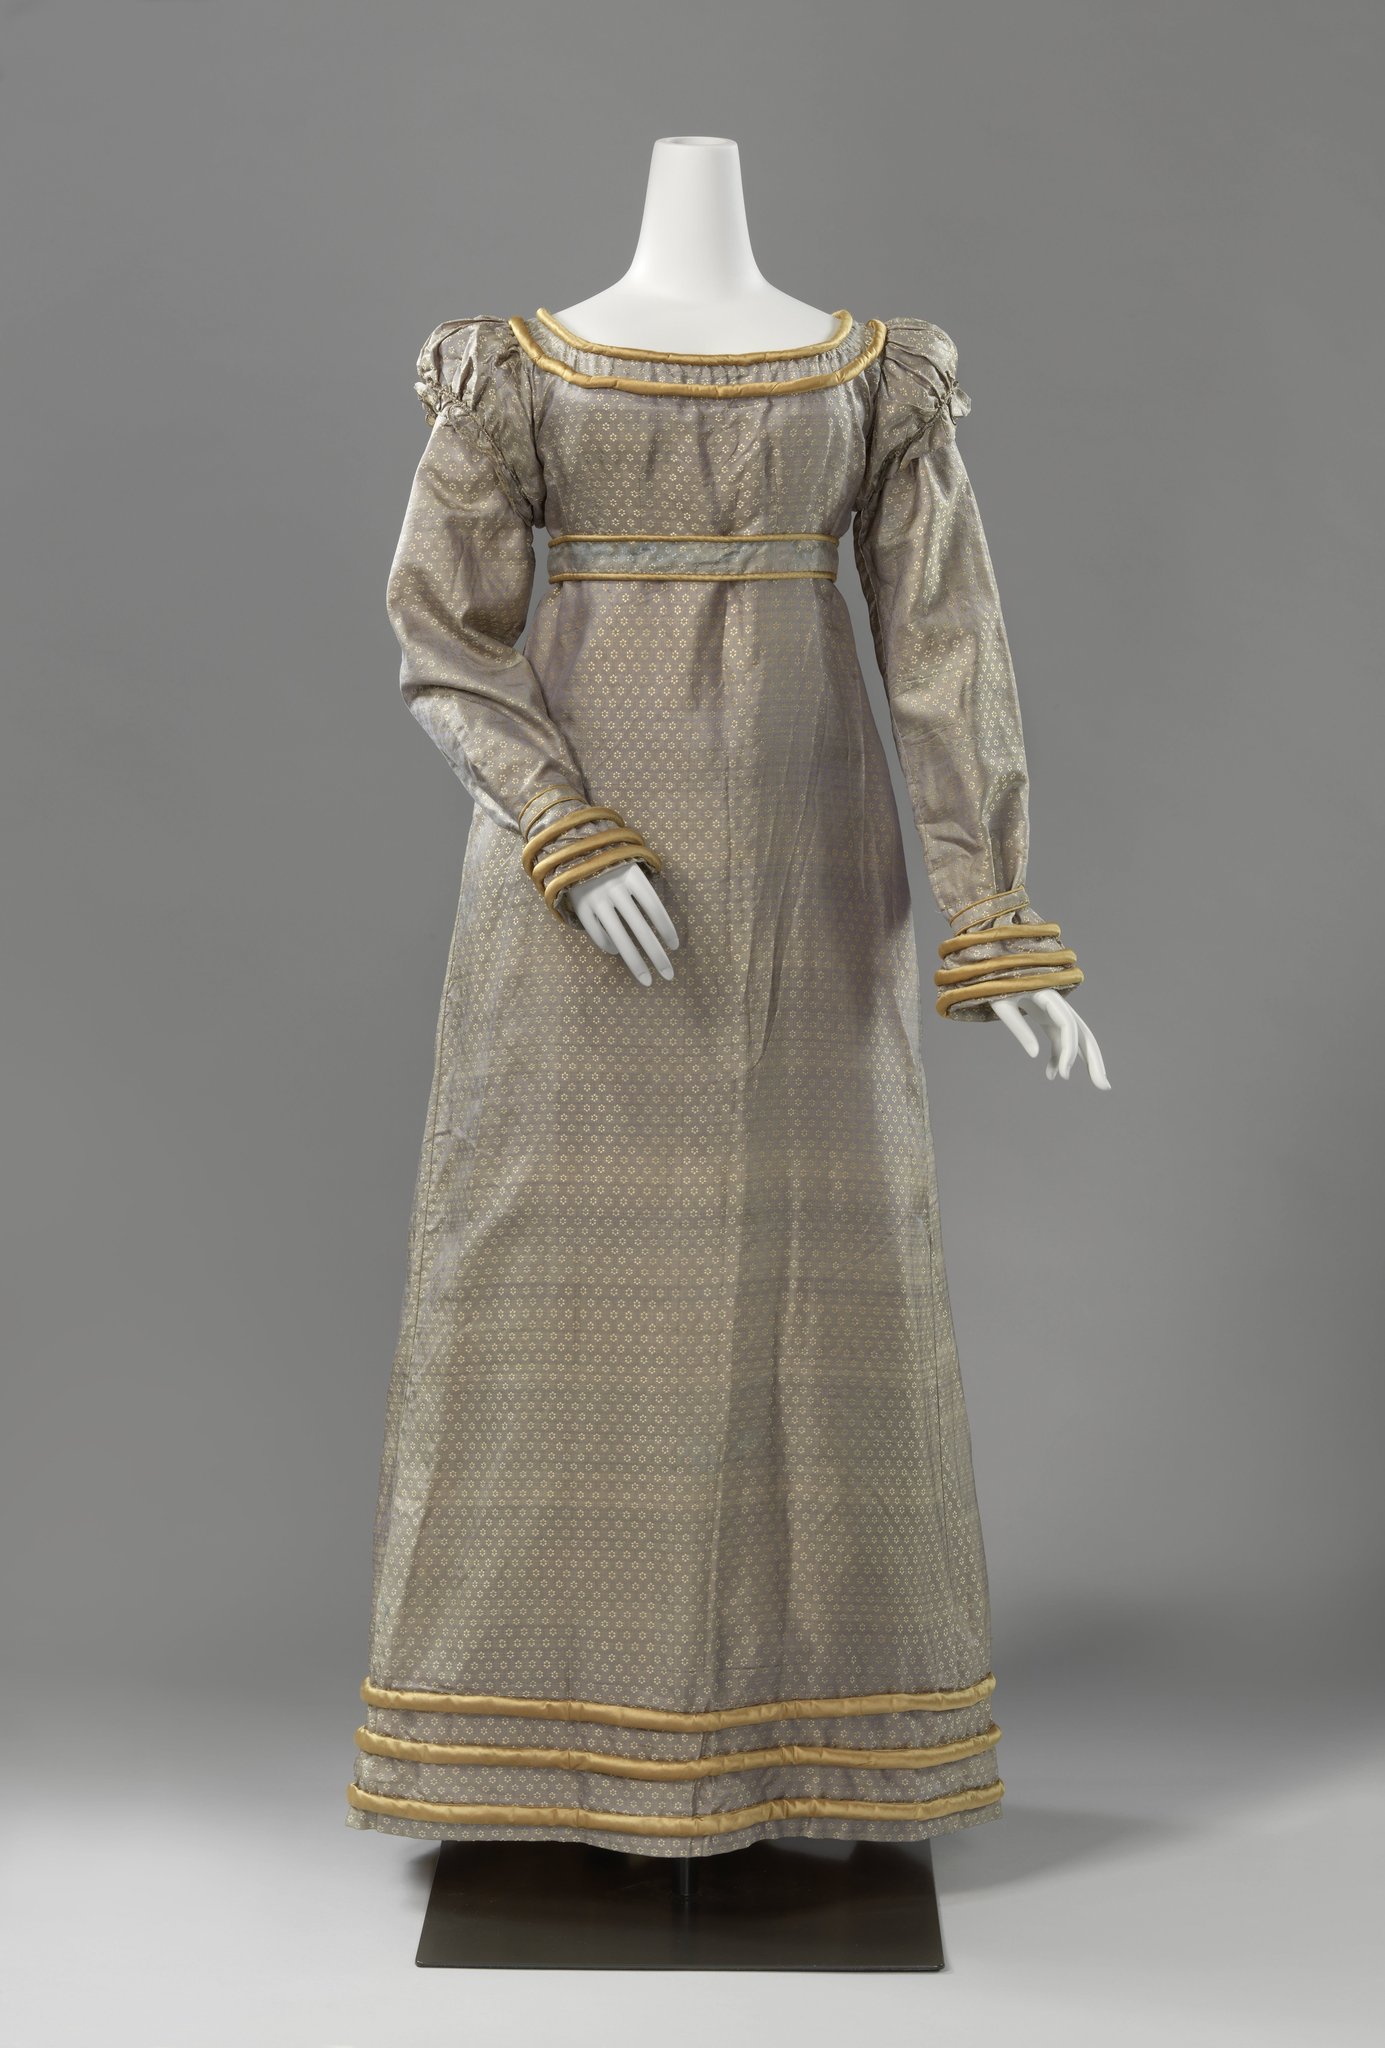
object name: robe, japon, jurk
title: Gown with a belt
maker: Anonymous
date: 1818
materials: cotton, linen, silk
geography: netherlands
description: During the first quarter of the 19th century, rouleaus, wadded rolls or coils, were often used to embellish dresses. These coils could be made out of various materials and in differing thicknesses, as well as in contrasting colours or patterns. The fabric was cut on the bias to ensure that the rolls could be filled to the maximum and puff out sufficiently.